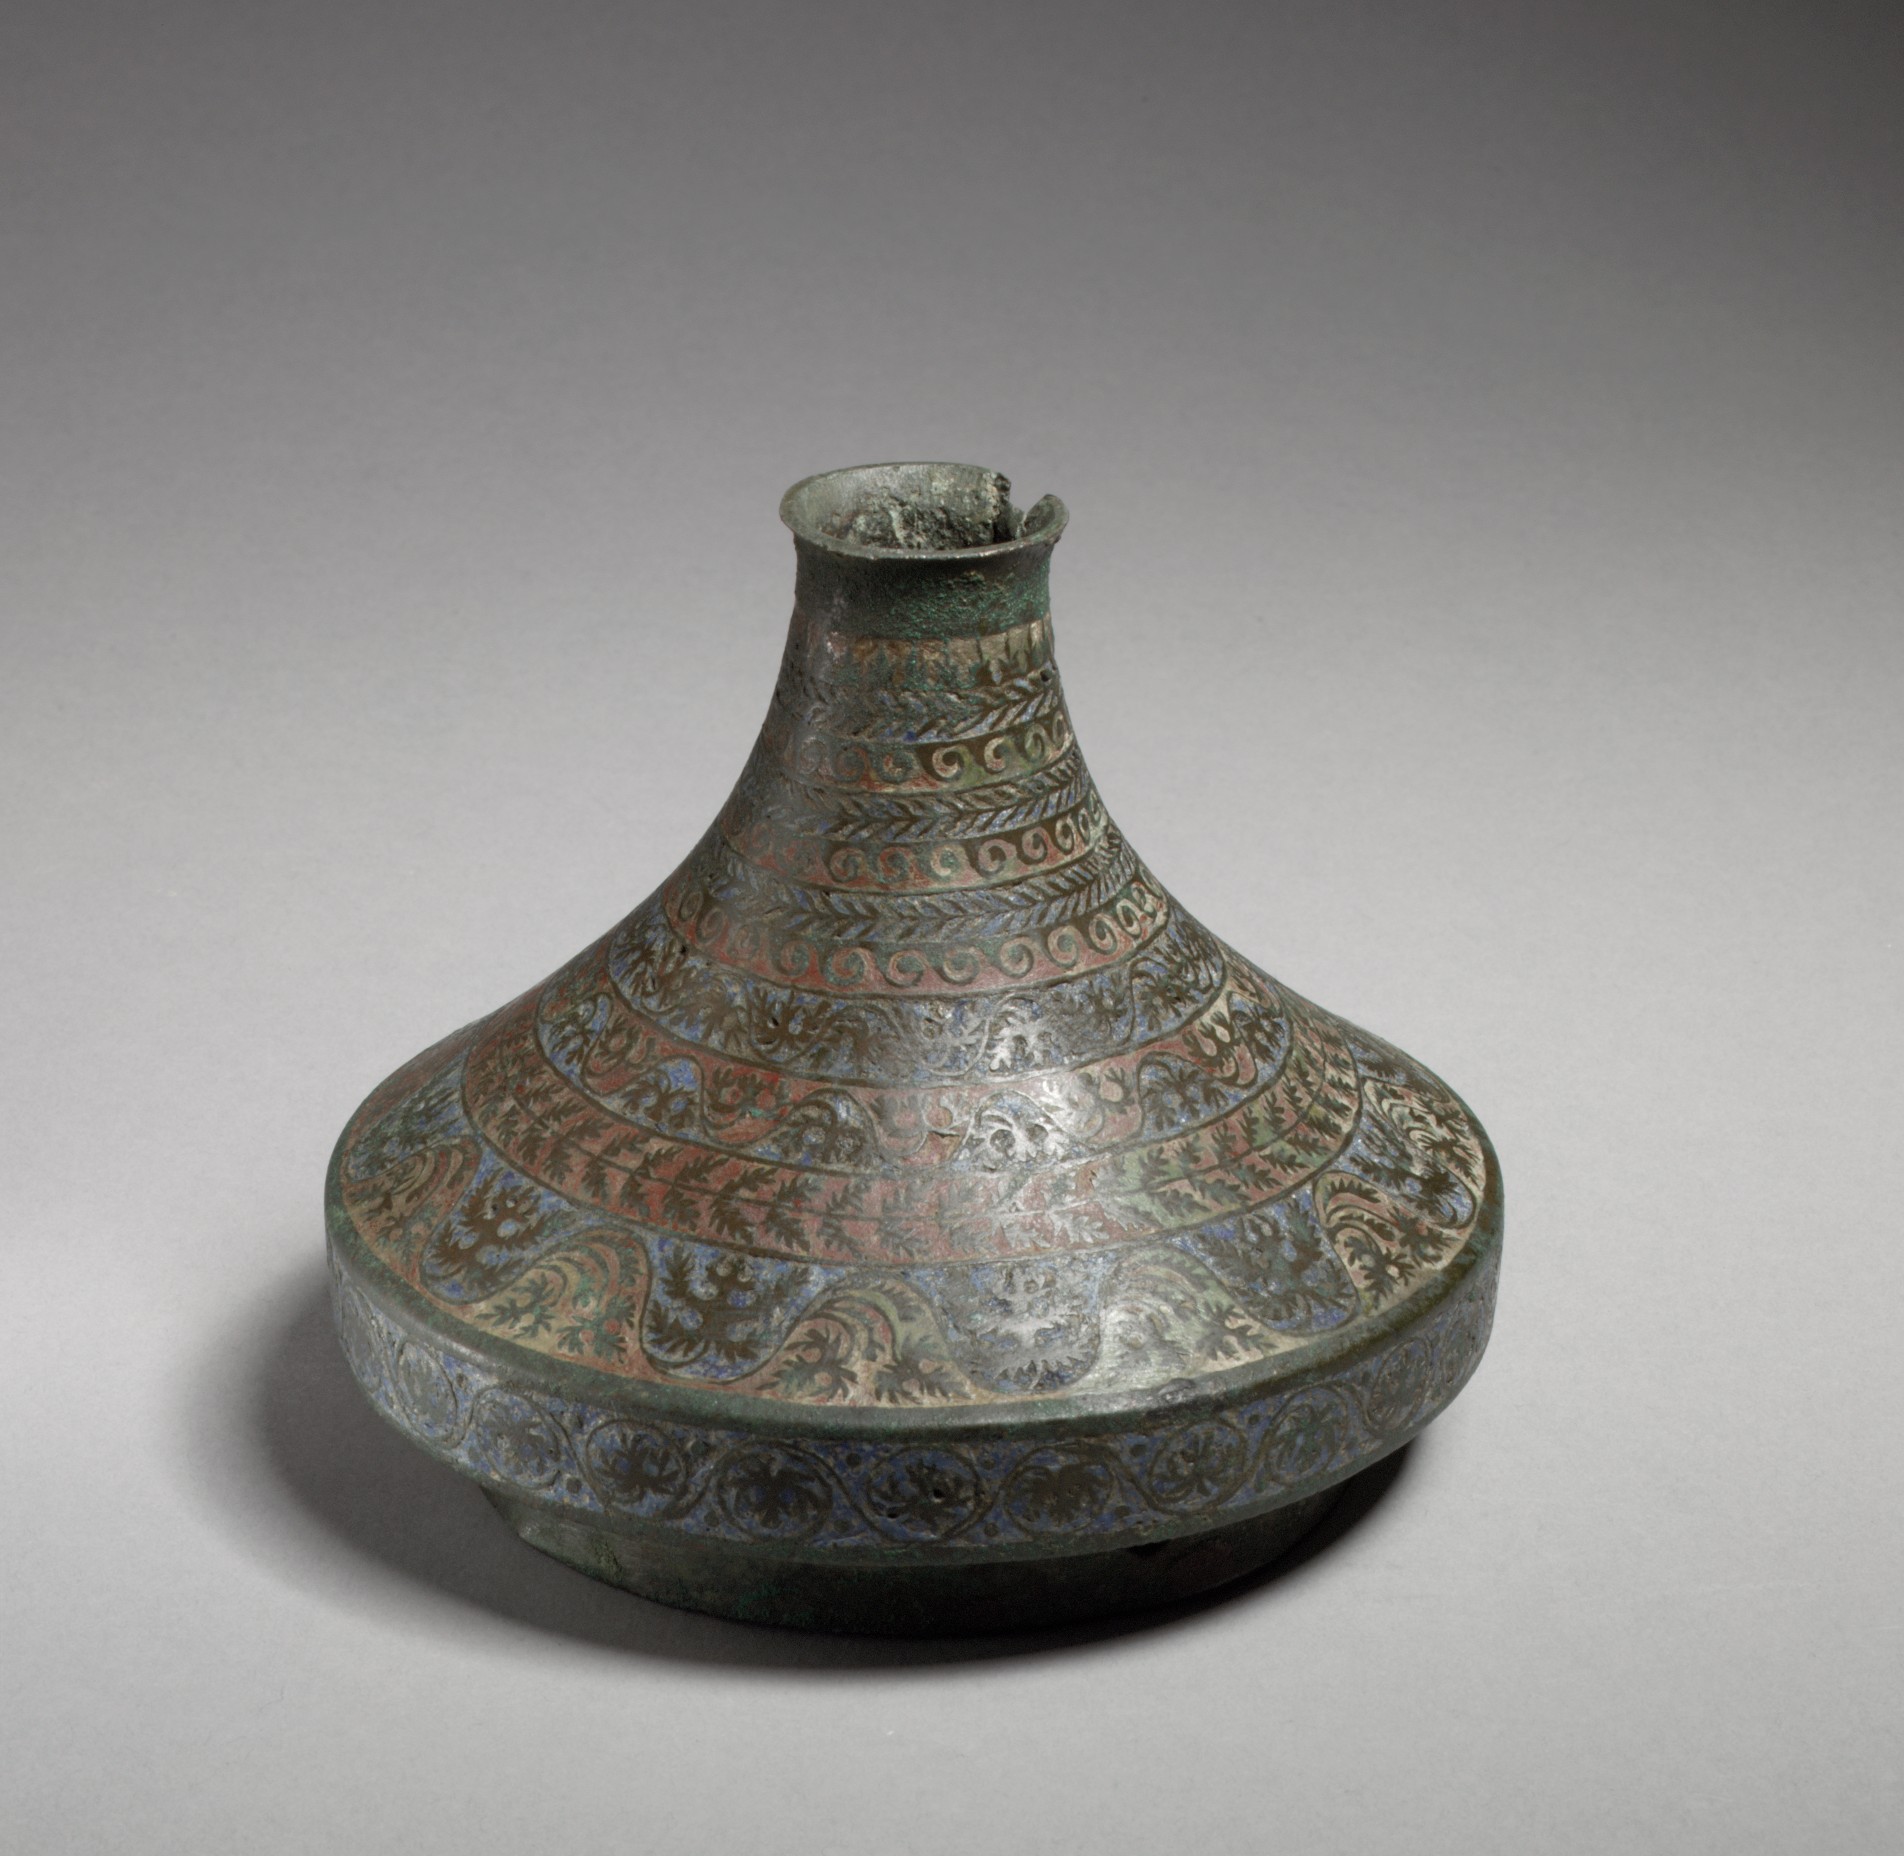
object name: finial mount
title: Funnel-Shaped Mount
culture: roman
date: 101-300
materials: bronze, enamel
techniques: enamel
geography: gaul